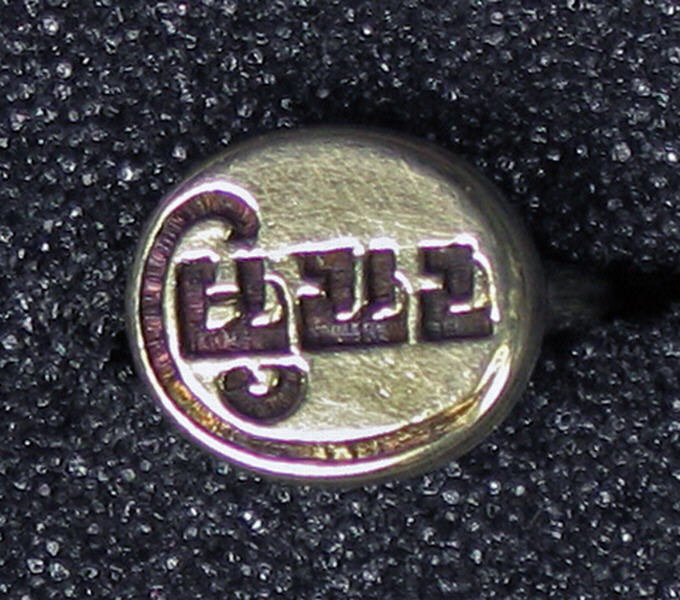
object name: ring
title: Ring with Oval Bezel and Javanese Calligraphy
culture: indonesian, central java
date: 701-1200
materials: gold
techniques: casting